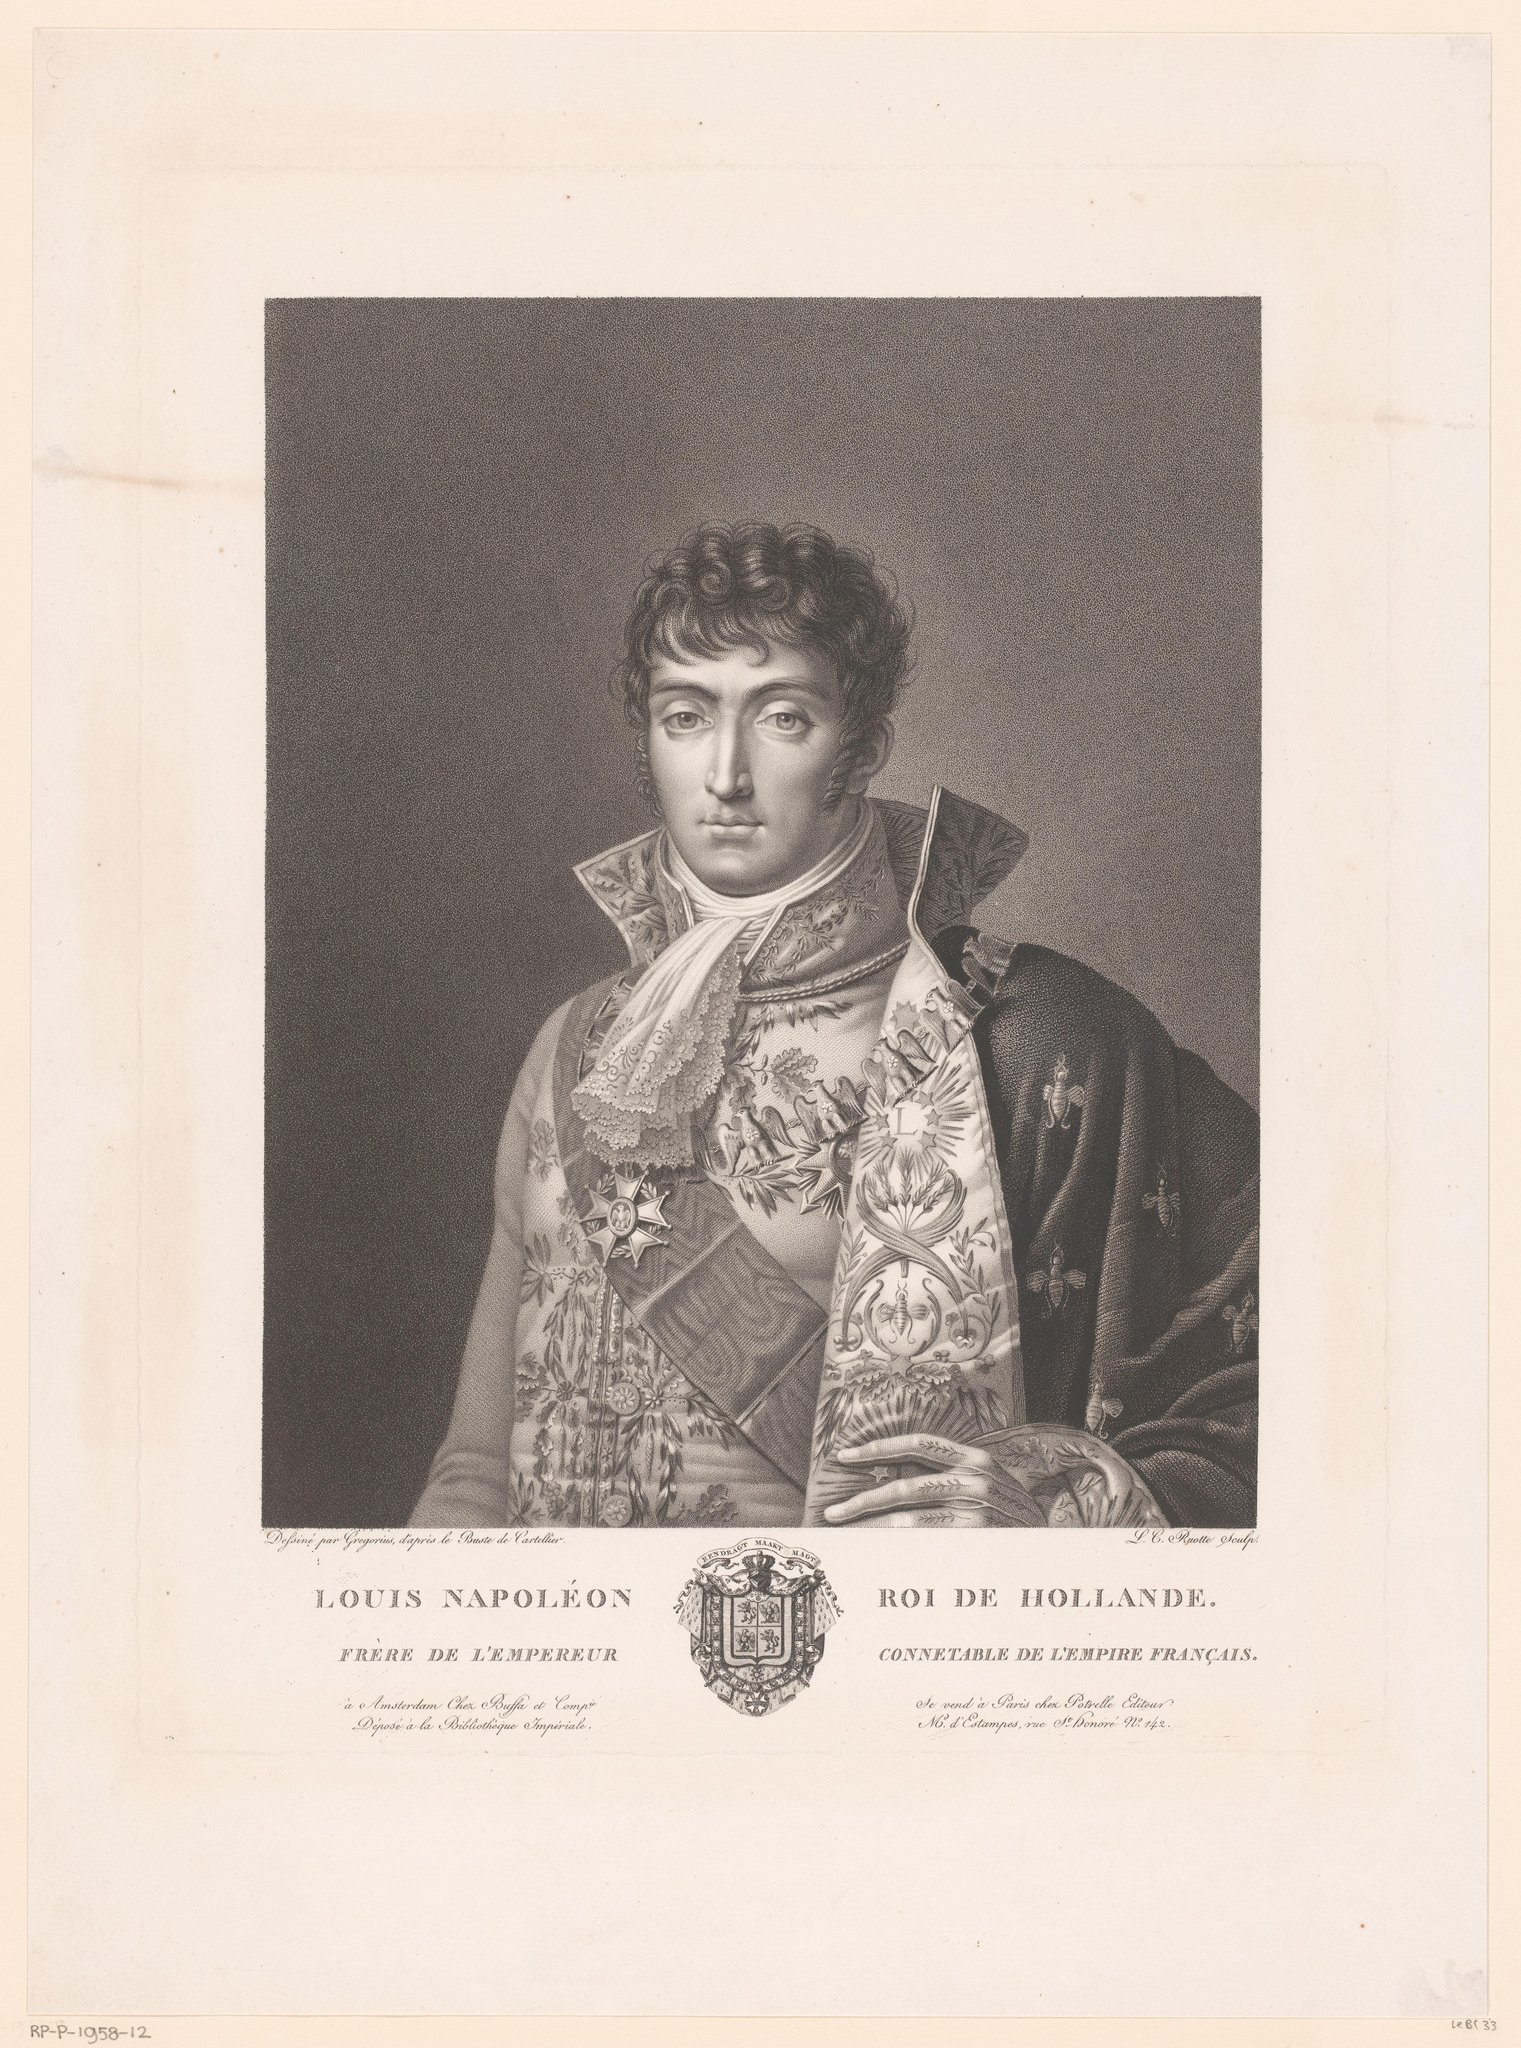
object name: print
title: Portret van Lodewijk Napoleon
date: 1764-1806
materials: paper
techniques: etching, roulette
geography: paris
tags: louis napoleon (king of holland), historical persons, king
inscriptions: : ‘Déposé à la Bibliothèque Impériale’, collector's mark: Lugt 2228